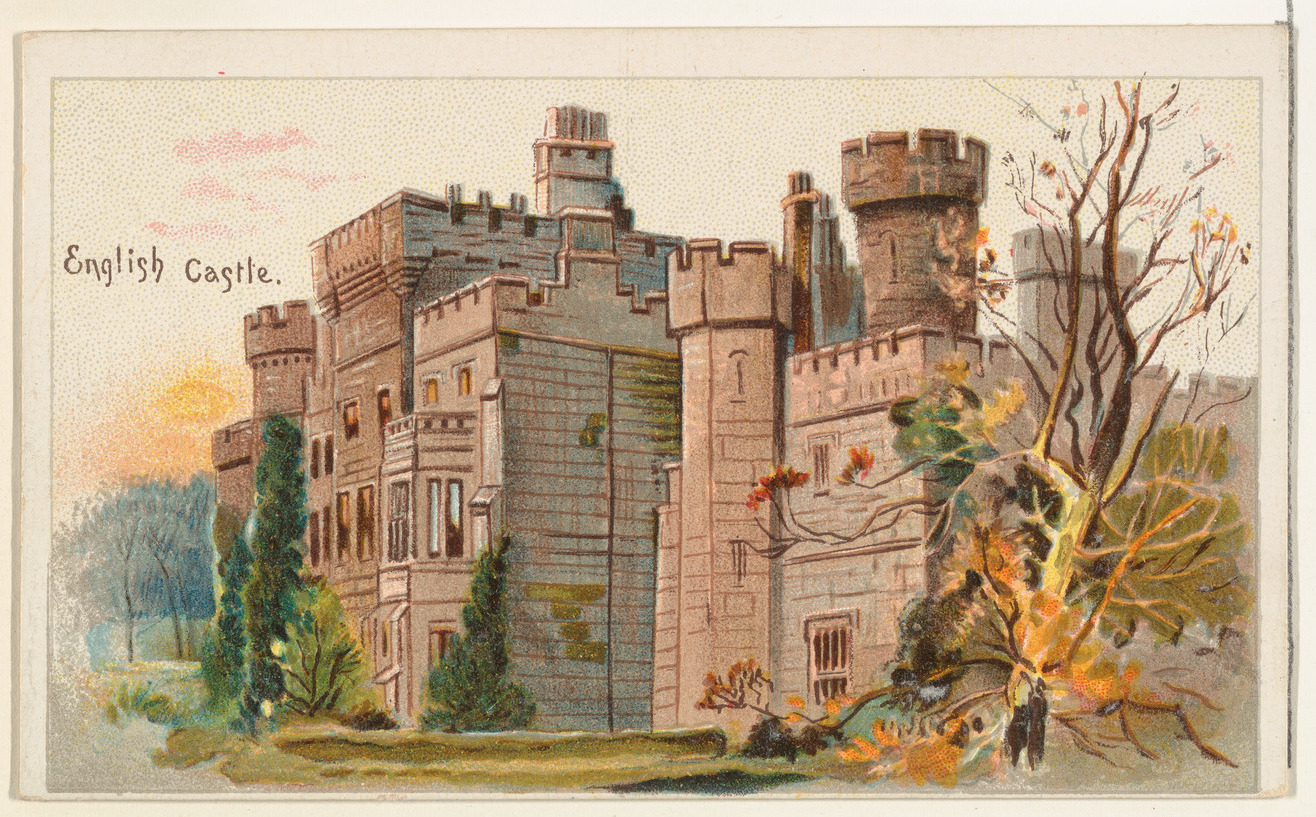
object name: print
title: English Castle, from the Habitations of Man series (N113) issued by W. Duke, Sons & Co. to promote Honest Long Cut Smoking and Chewing Tobacco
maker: the giles company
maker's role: artist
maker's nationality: american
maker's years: 1800-1900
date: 1890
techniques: color lithograph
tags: castles